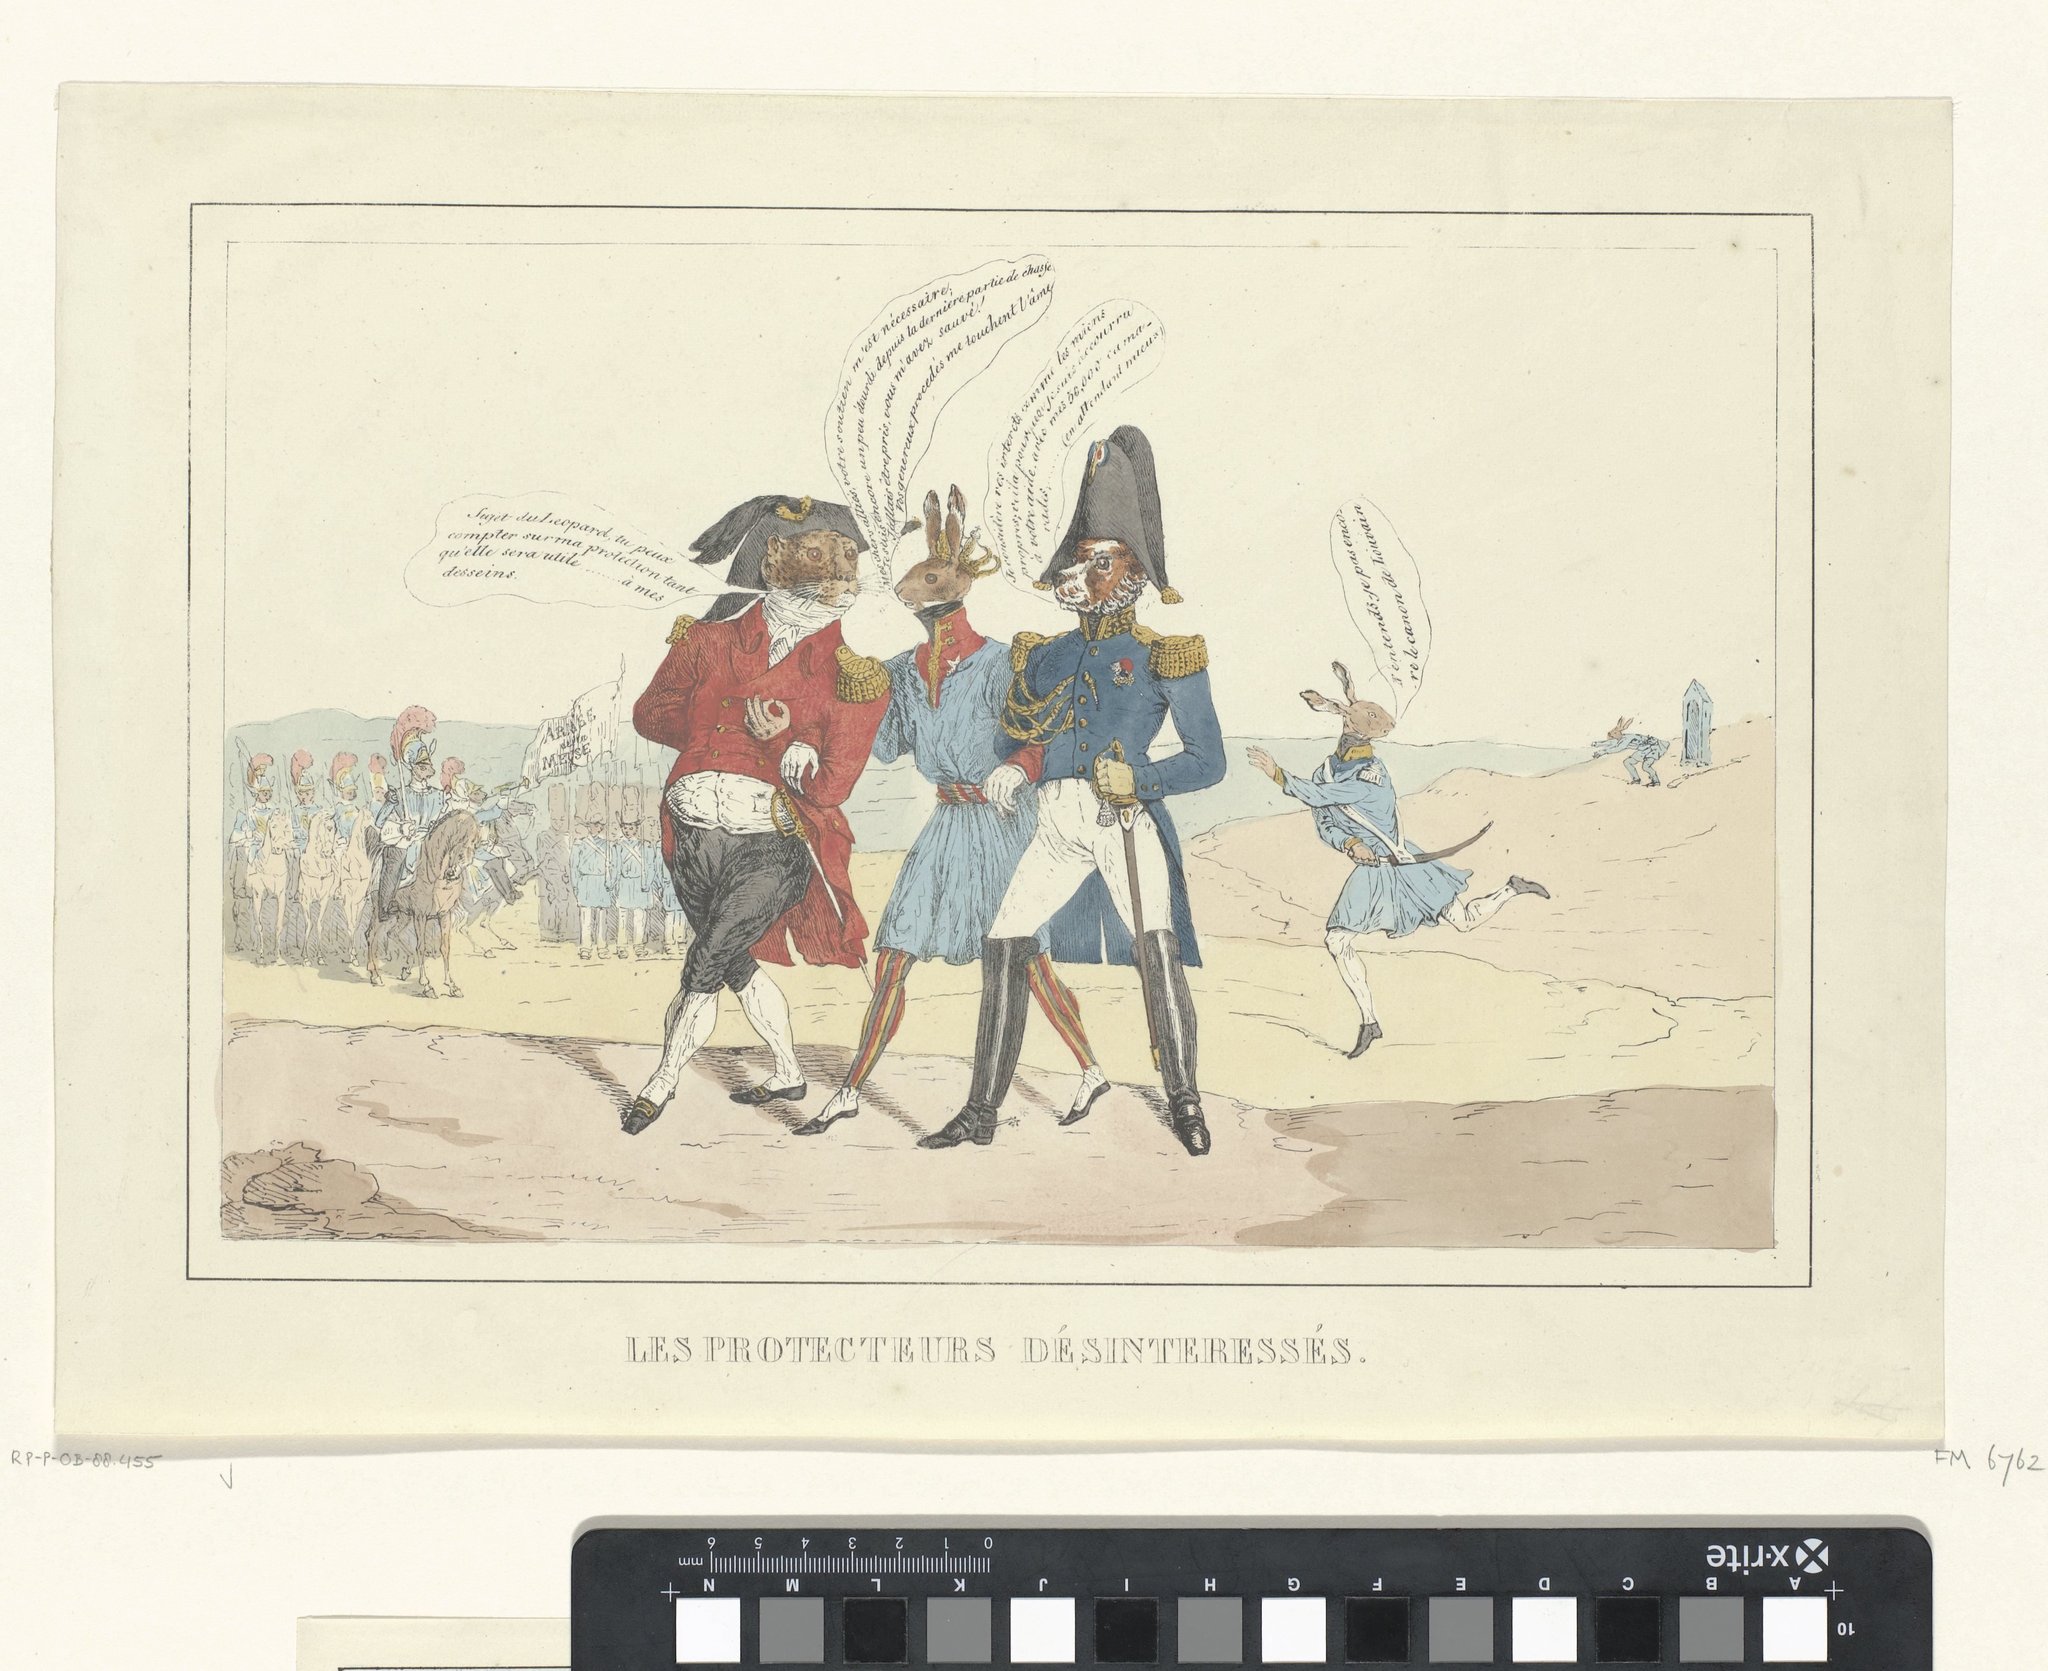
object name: cartoon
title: Les Protecteurs Désinteressés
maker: paulus charles gerard poelman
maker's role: draughtsman, painter, print maker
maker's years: 1792-1846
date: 1831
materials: paper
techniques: hand coloring, lithograph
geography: netherlands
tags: leopold i (koning der belgen), animals acting as human beings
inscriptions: collector's mark: Lugt 2228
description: Spotprent op de bescherming geboden aan België door Groot-Brittannië en Frankrijk, 1831. Een gekroonde haas, koning Leopold I, loopt gearmd met een luipaard (Groot-Brittannië) en een hond (Frankrijk). Links op de achtergrond de Armée de la Meuse, rechts een vluchtende haas.